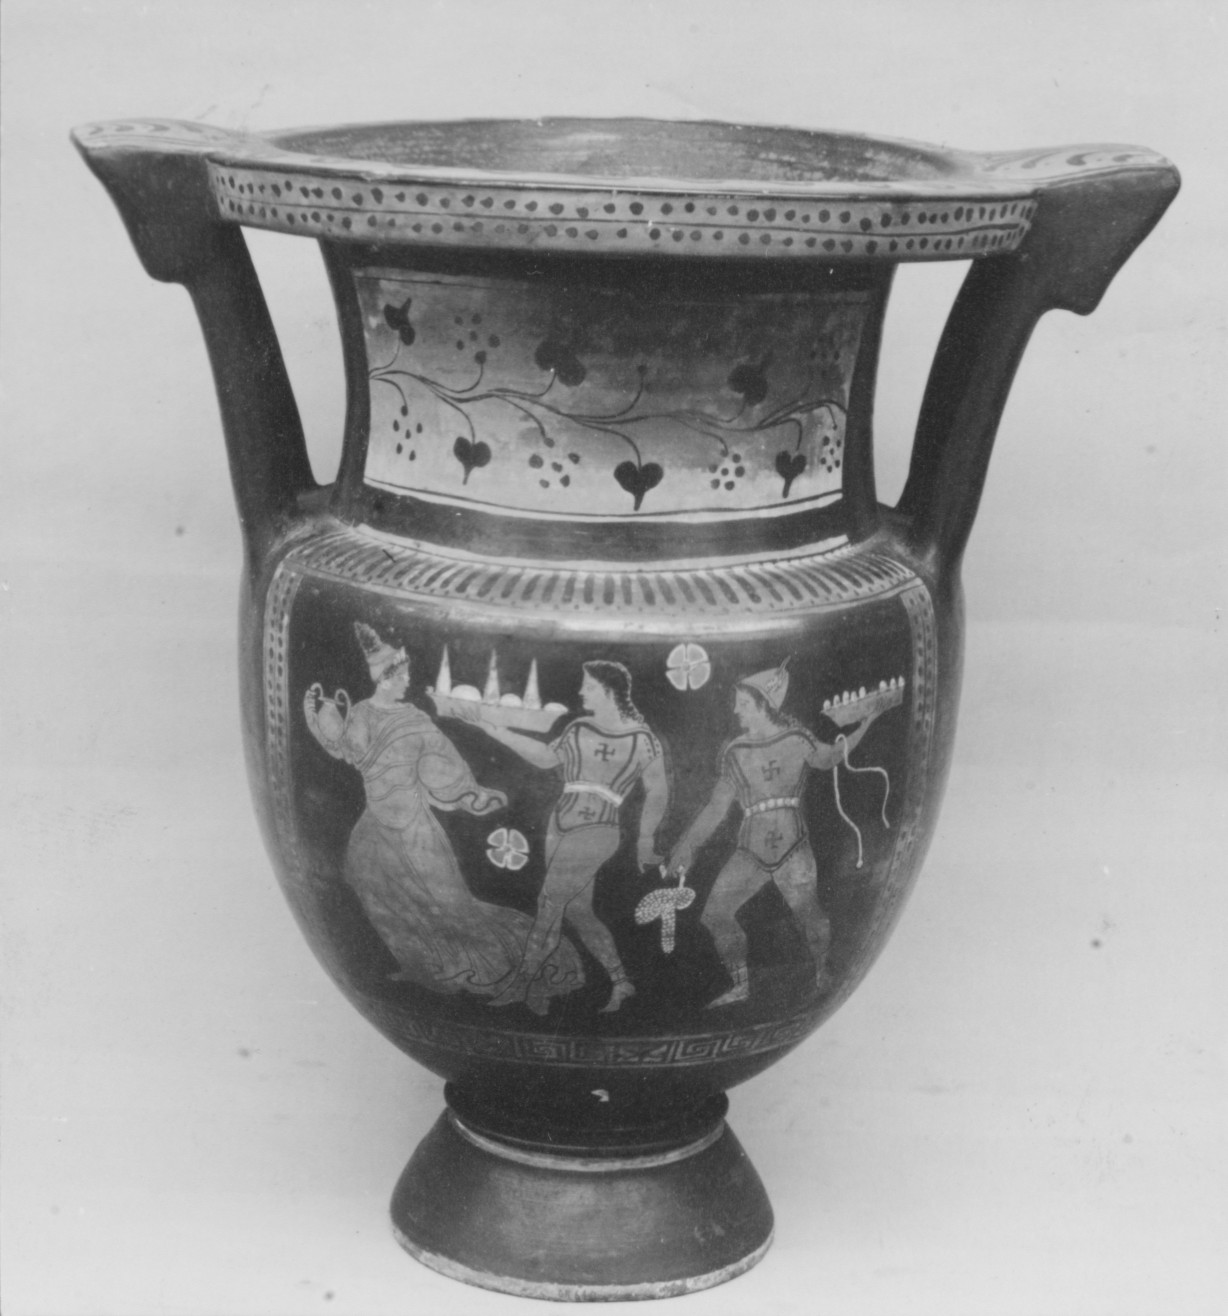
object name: column krater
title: Terracotta column-krater (mixing bowl)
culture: greek, south italian, apulian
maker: painter of the bari orestes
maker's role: artist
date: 375-350 BCE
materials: terracotta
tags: men,women,processions